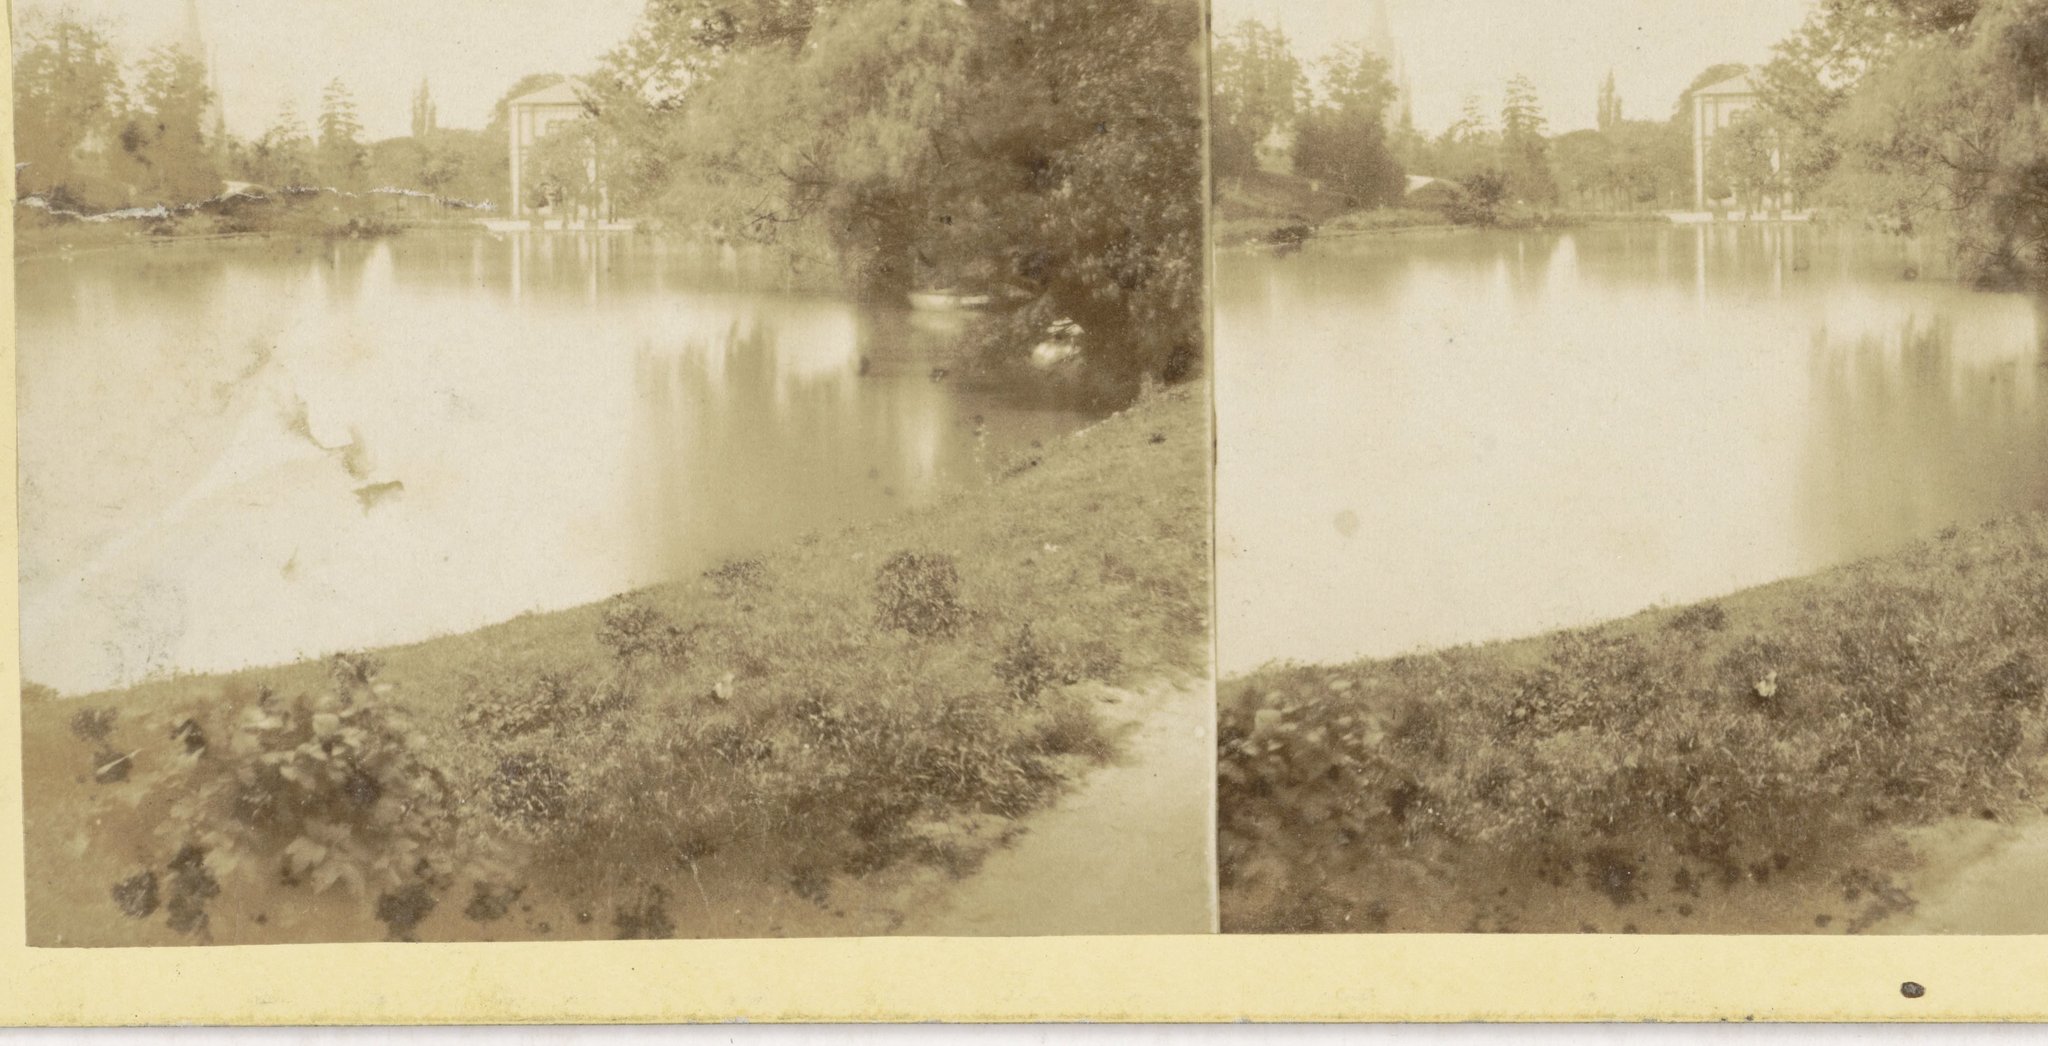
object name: stereograph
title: Le Jardin du kursaal, à Wiesbaden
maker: Anonymous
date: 1861-1870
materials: cardboard, paper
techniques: albumen print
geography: wiesbaden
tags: watering-place, spa, garden pond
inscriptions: number: ‘No 67’